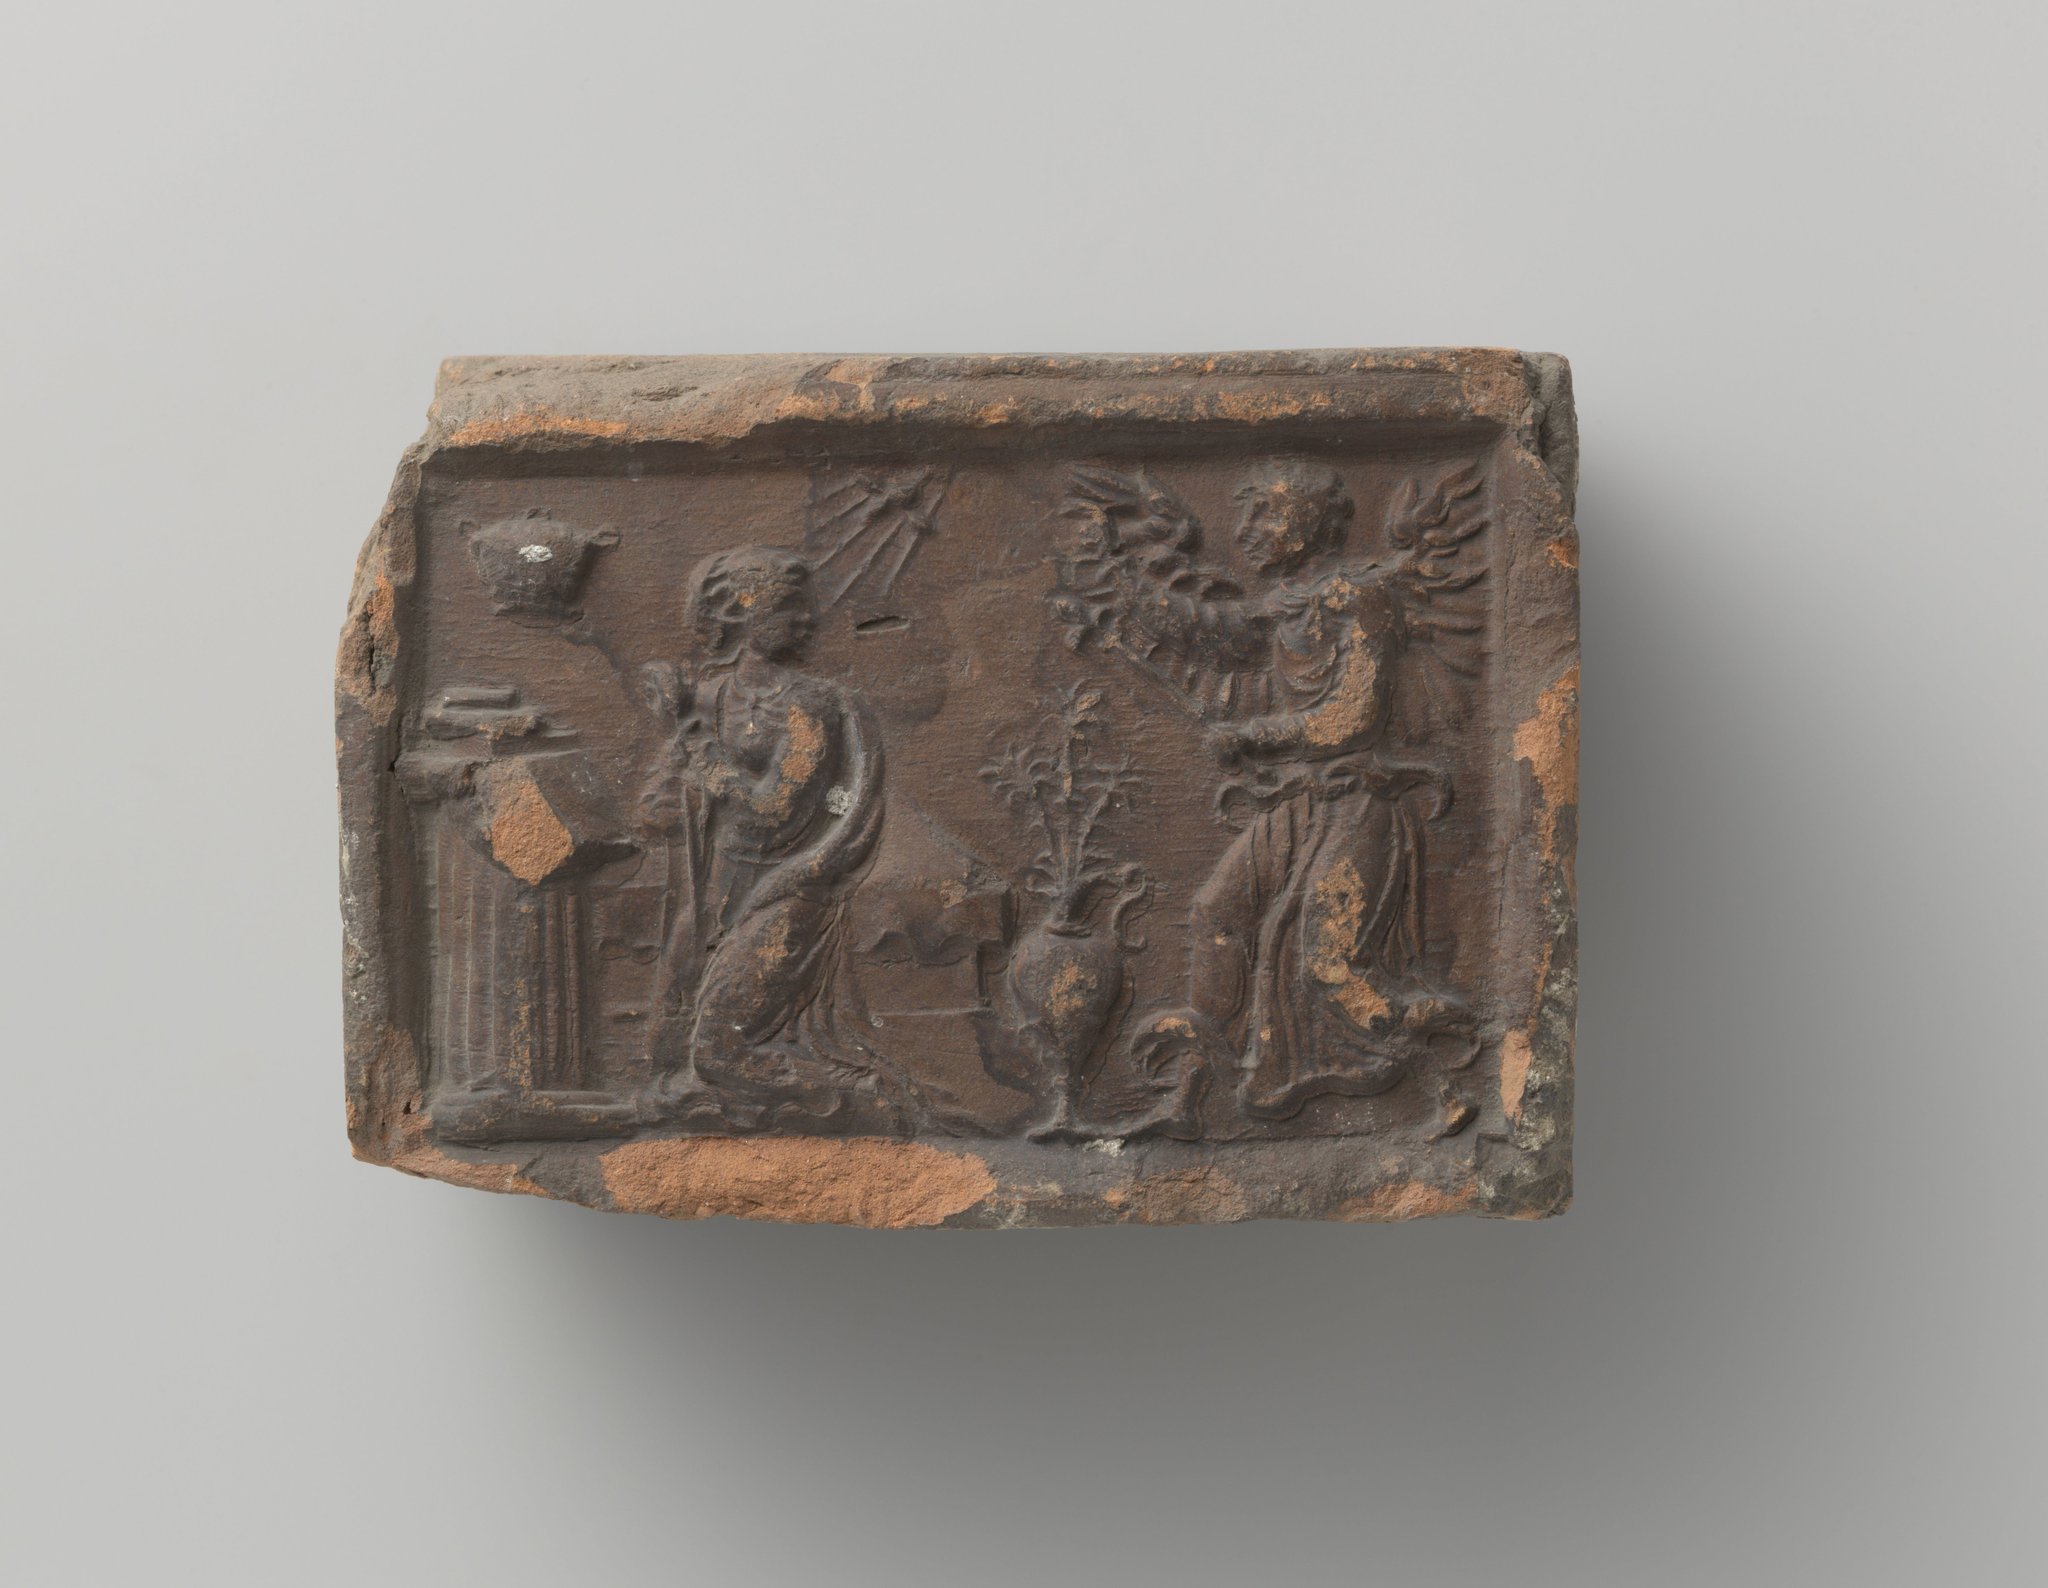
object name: hearthstone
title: Haardsteen, waarop Maria die de blijde boodschap ontvangt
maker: Anonymous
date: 1500-1600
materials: earthenware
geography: southern netherlands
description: Haardsteen, waarop Maria die de blijde boodschap ontvangt. Van fijne gebakken aarde.